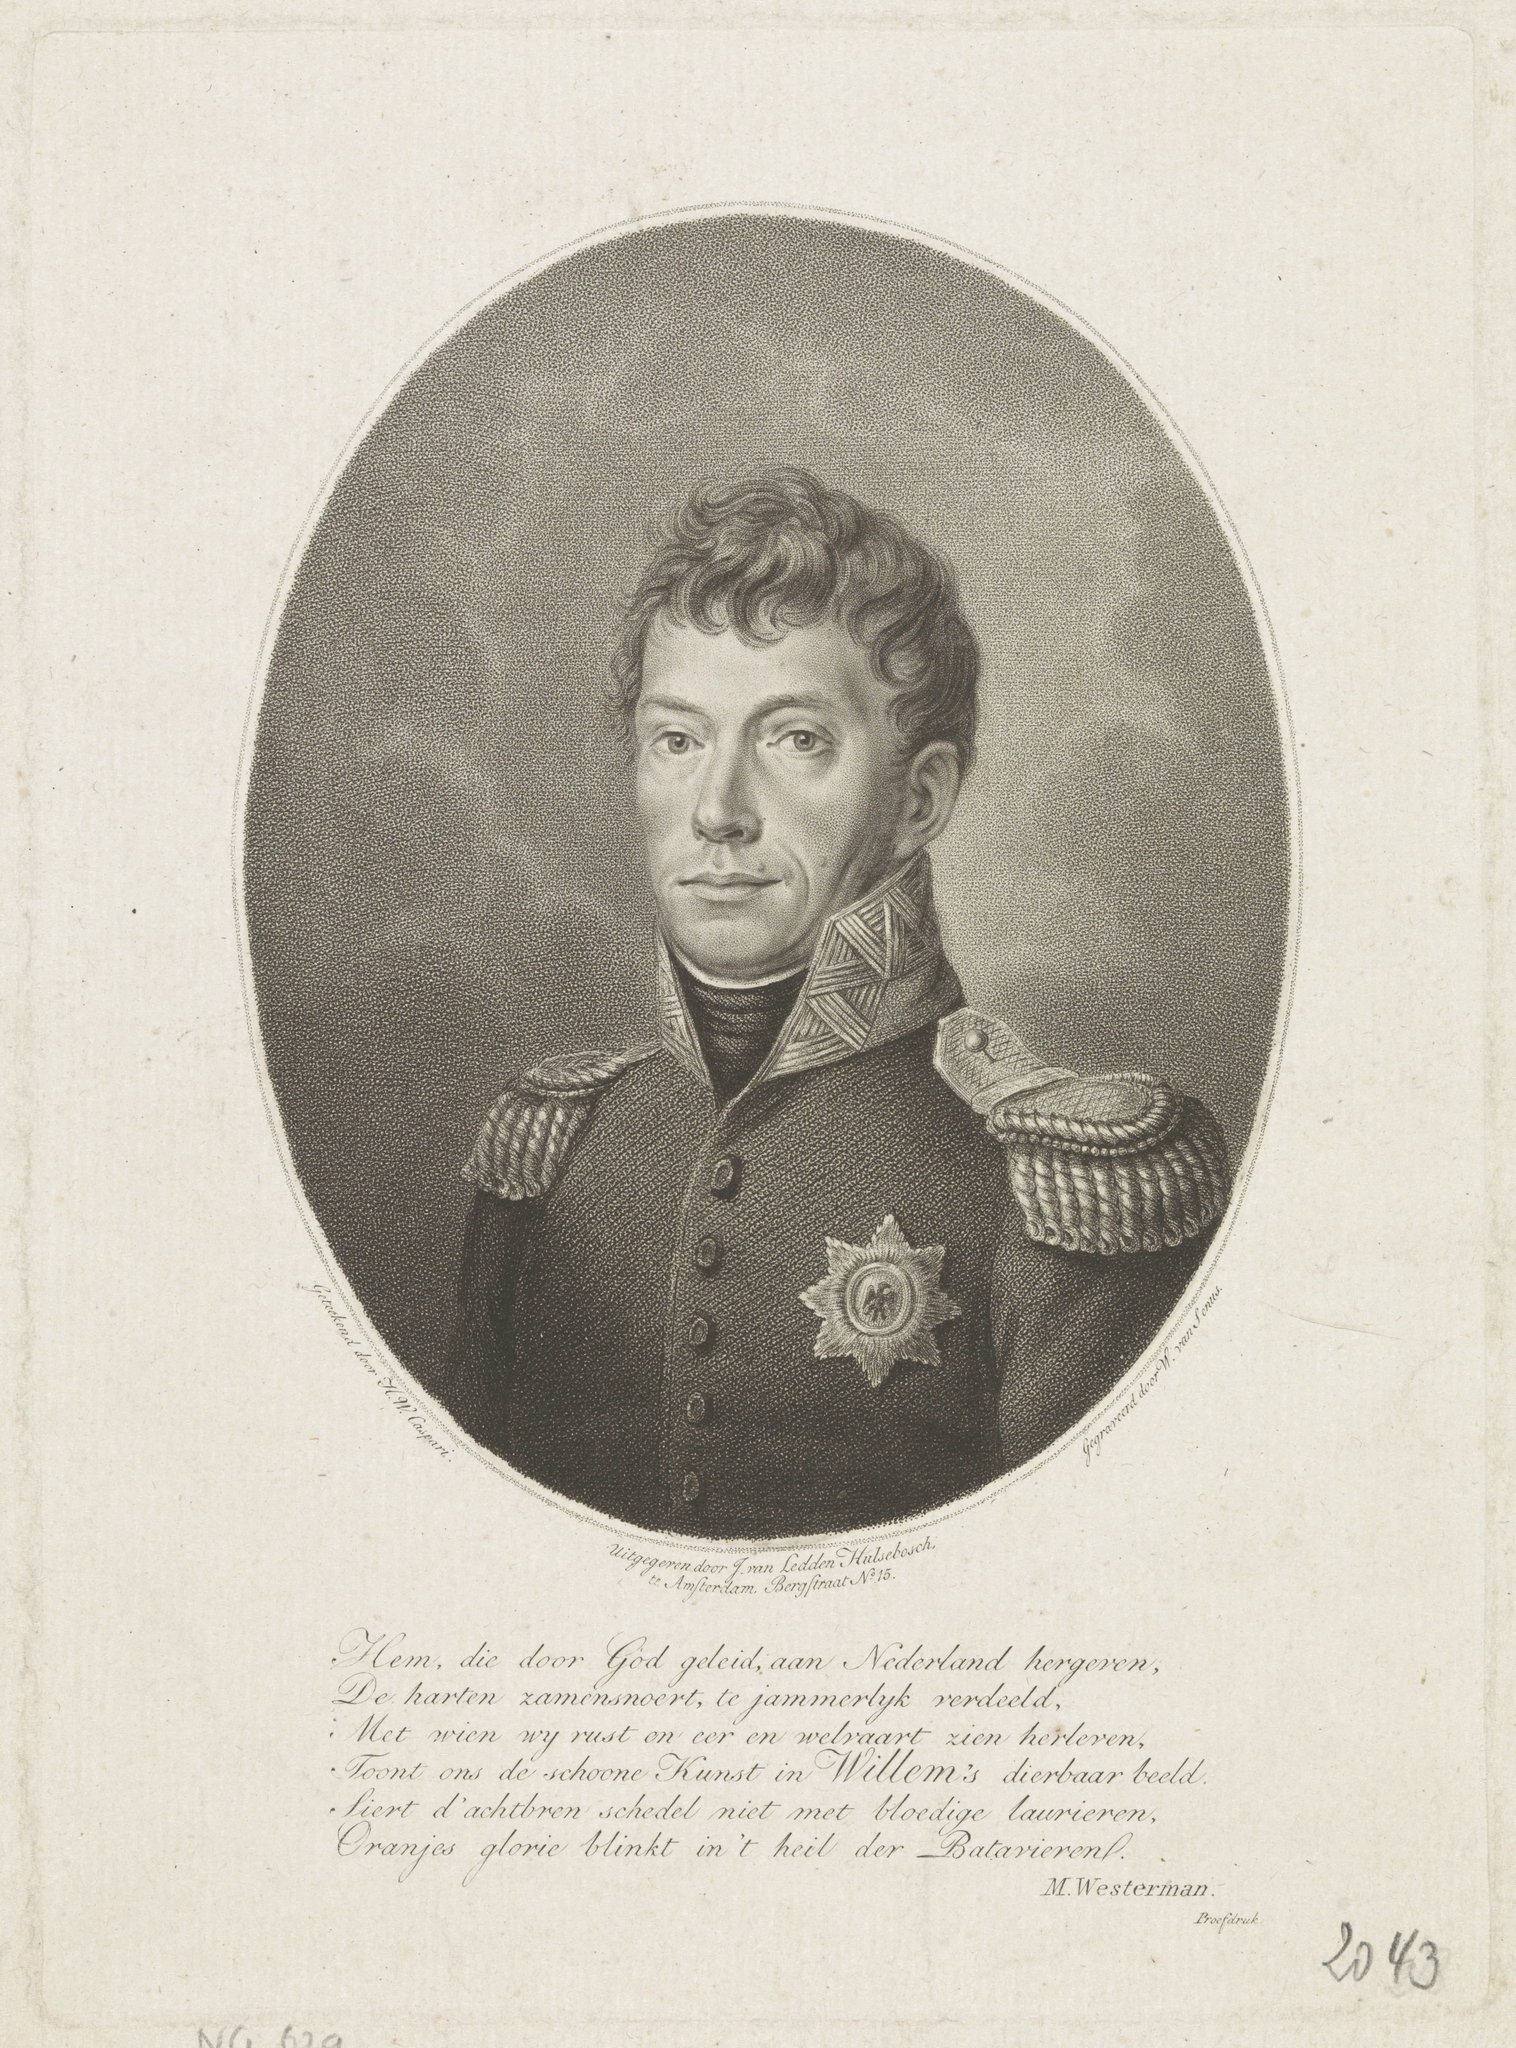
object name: print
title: Portret van Willem I Frederik, koning der Nederlanden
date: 1813-1819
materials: paper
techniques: engraving, etching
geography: amsterdam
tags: the hague, william i of the netherlands, knighthood order (with name) - insignia of a knighthood order, e.g.: badge, chain (with name of order)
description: De hier vermelde titel verwijst naar de hoogst verkregen titel van de geportretteerde, niet per se naar de titel die de geportretteerde op deze voorstelling draagt.